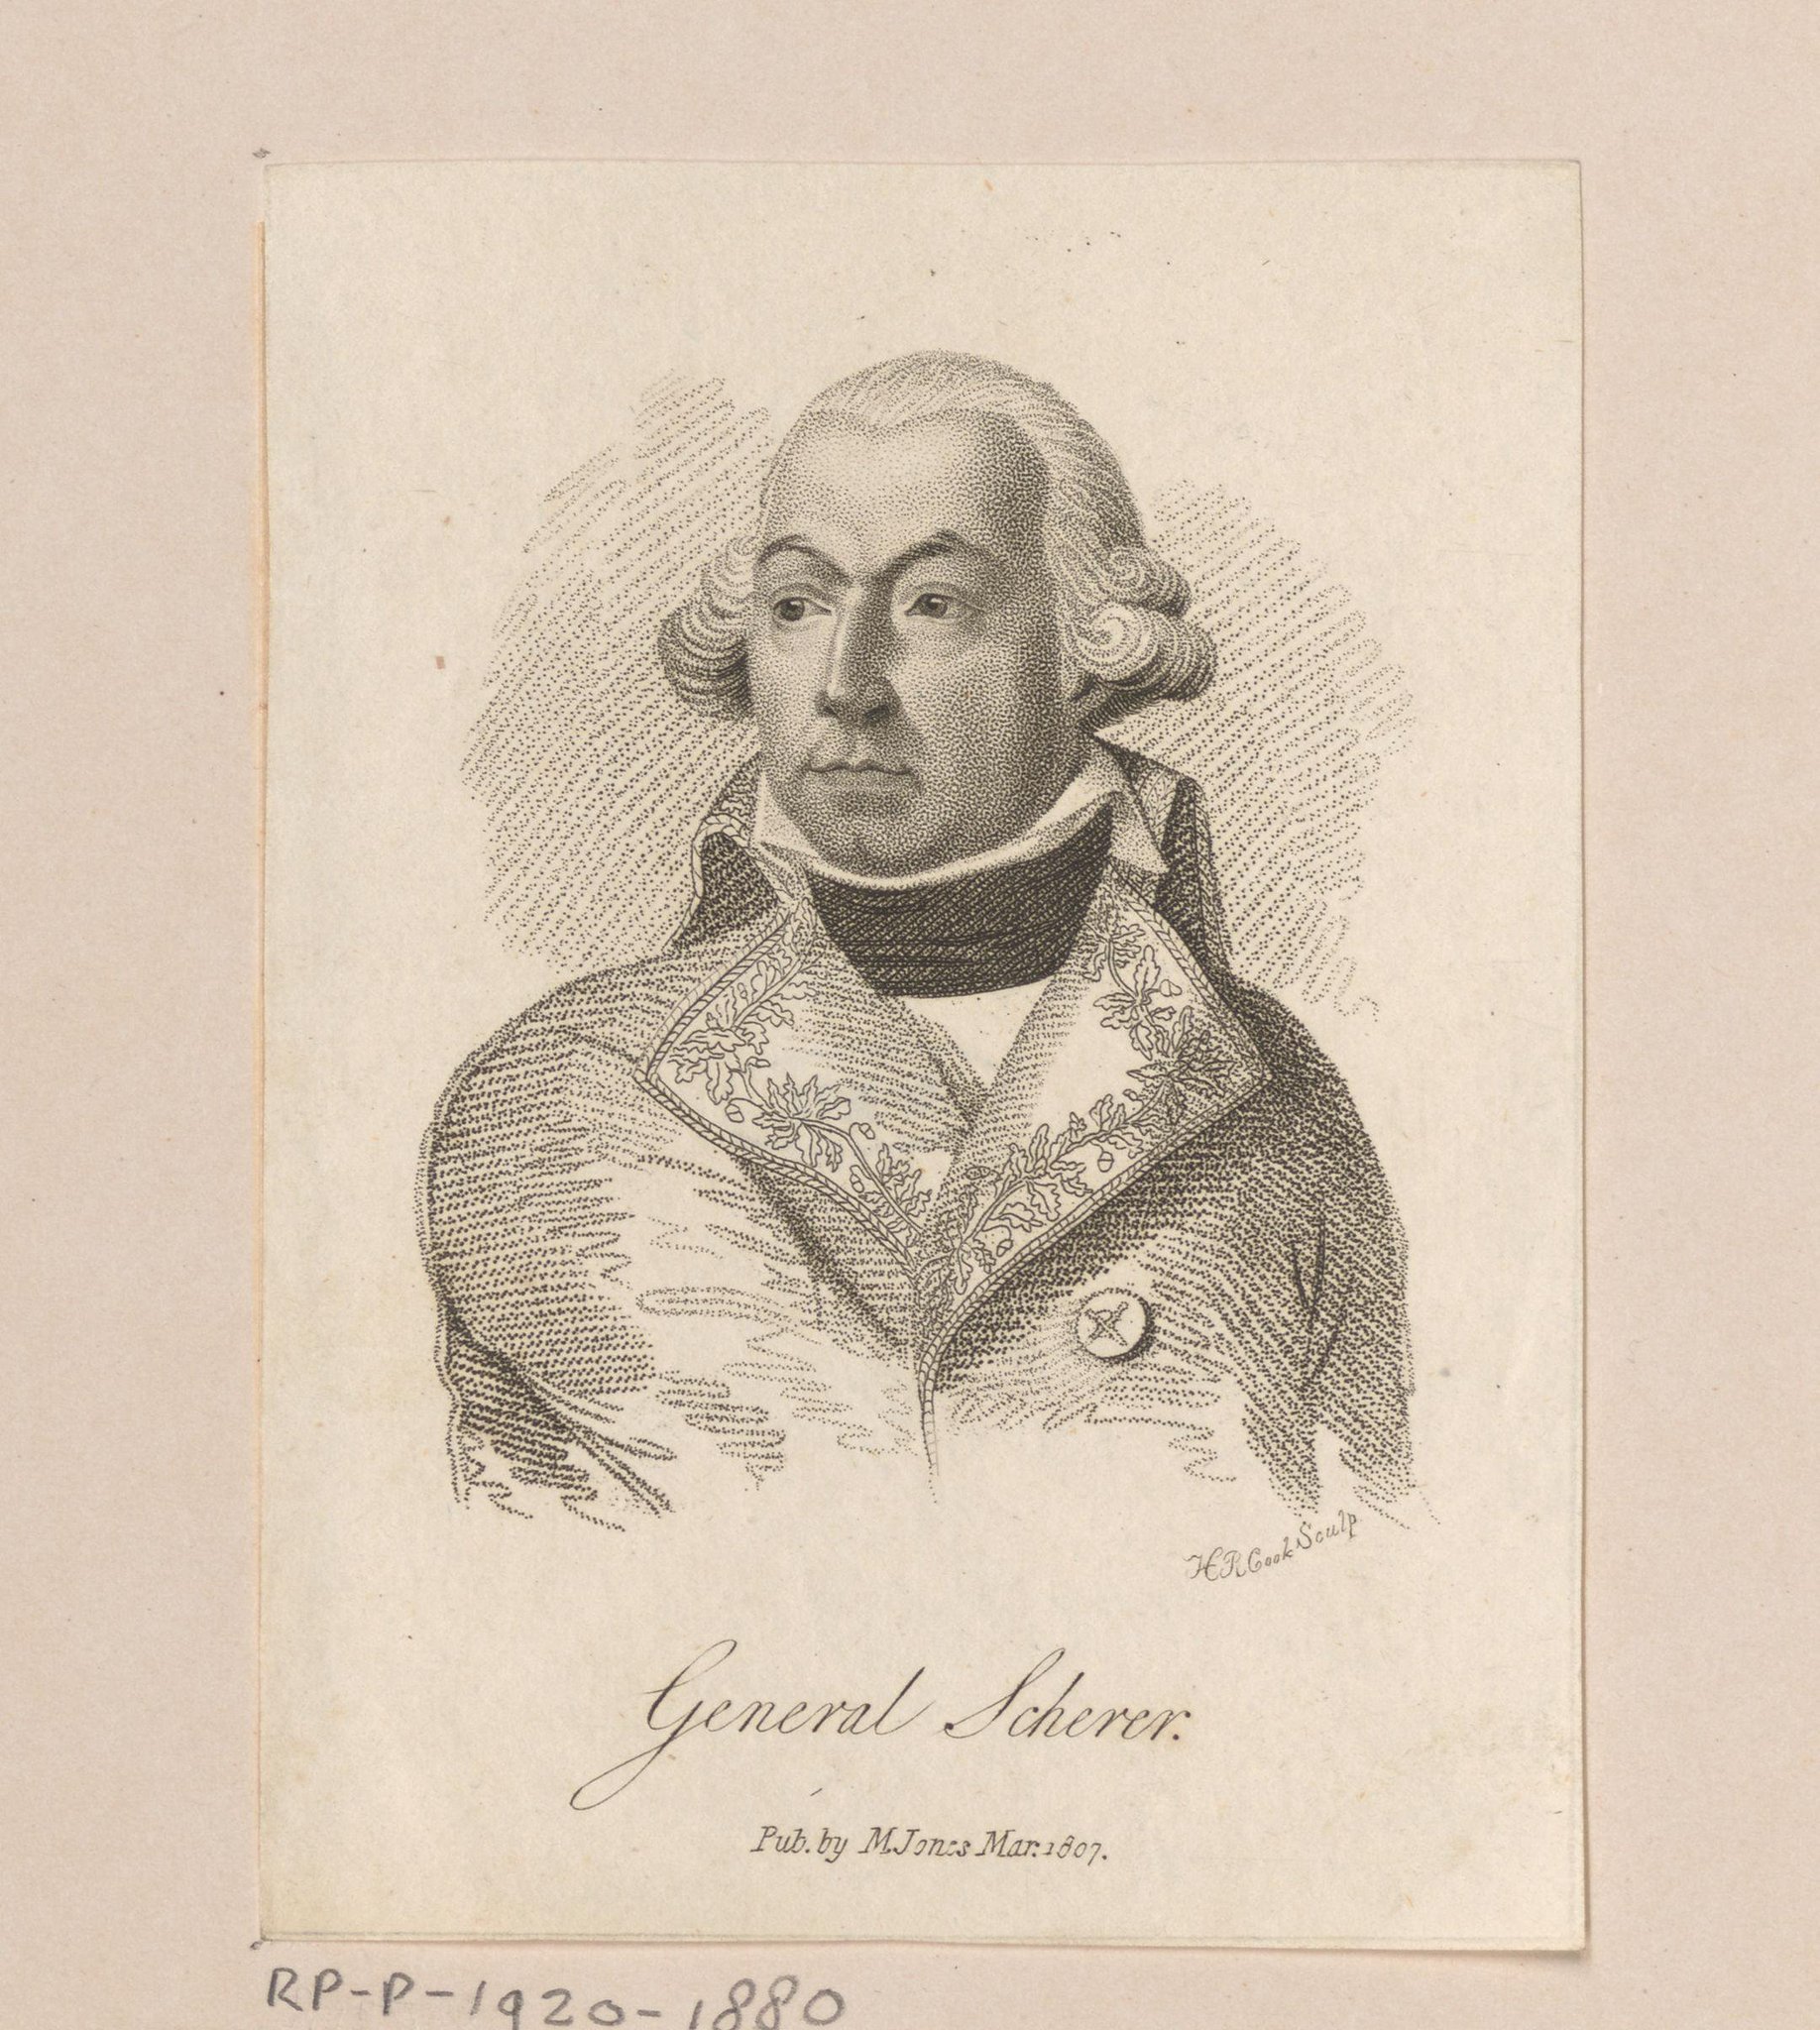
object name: print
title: Portret van Barthélemy Louis Joseph Schérer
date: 1803-1807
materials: paper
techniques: etching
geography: london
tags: commander-in-chief, general, marshal, historical persons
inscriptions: collector's mark: Lugt 2228